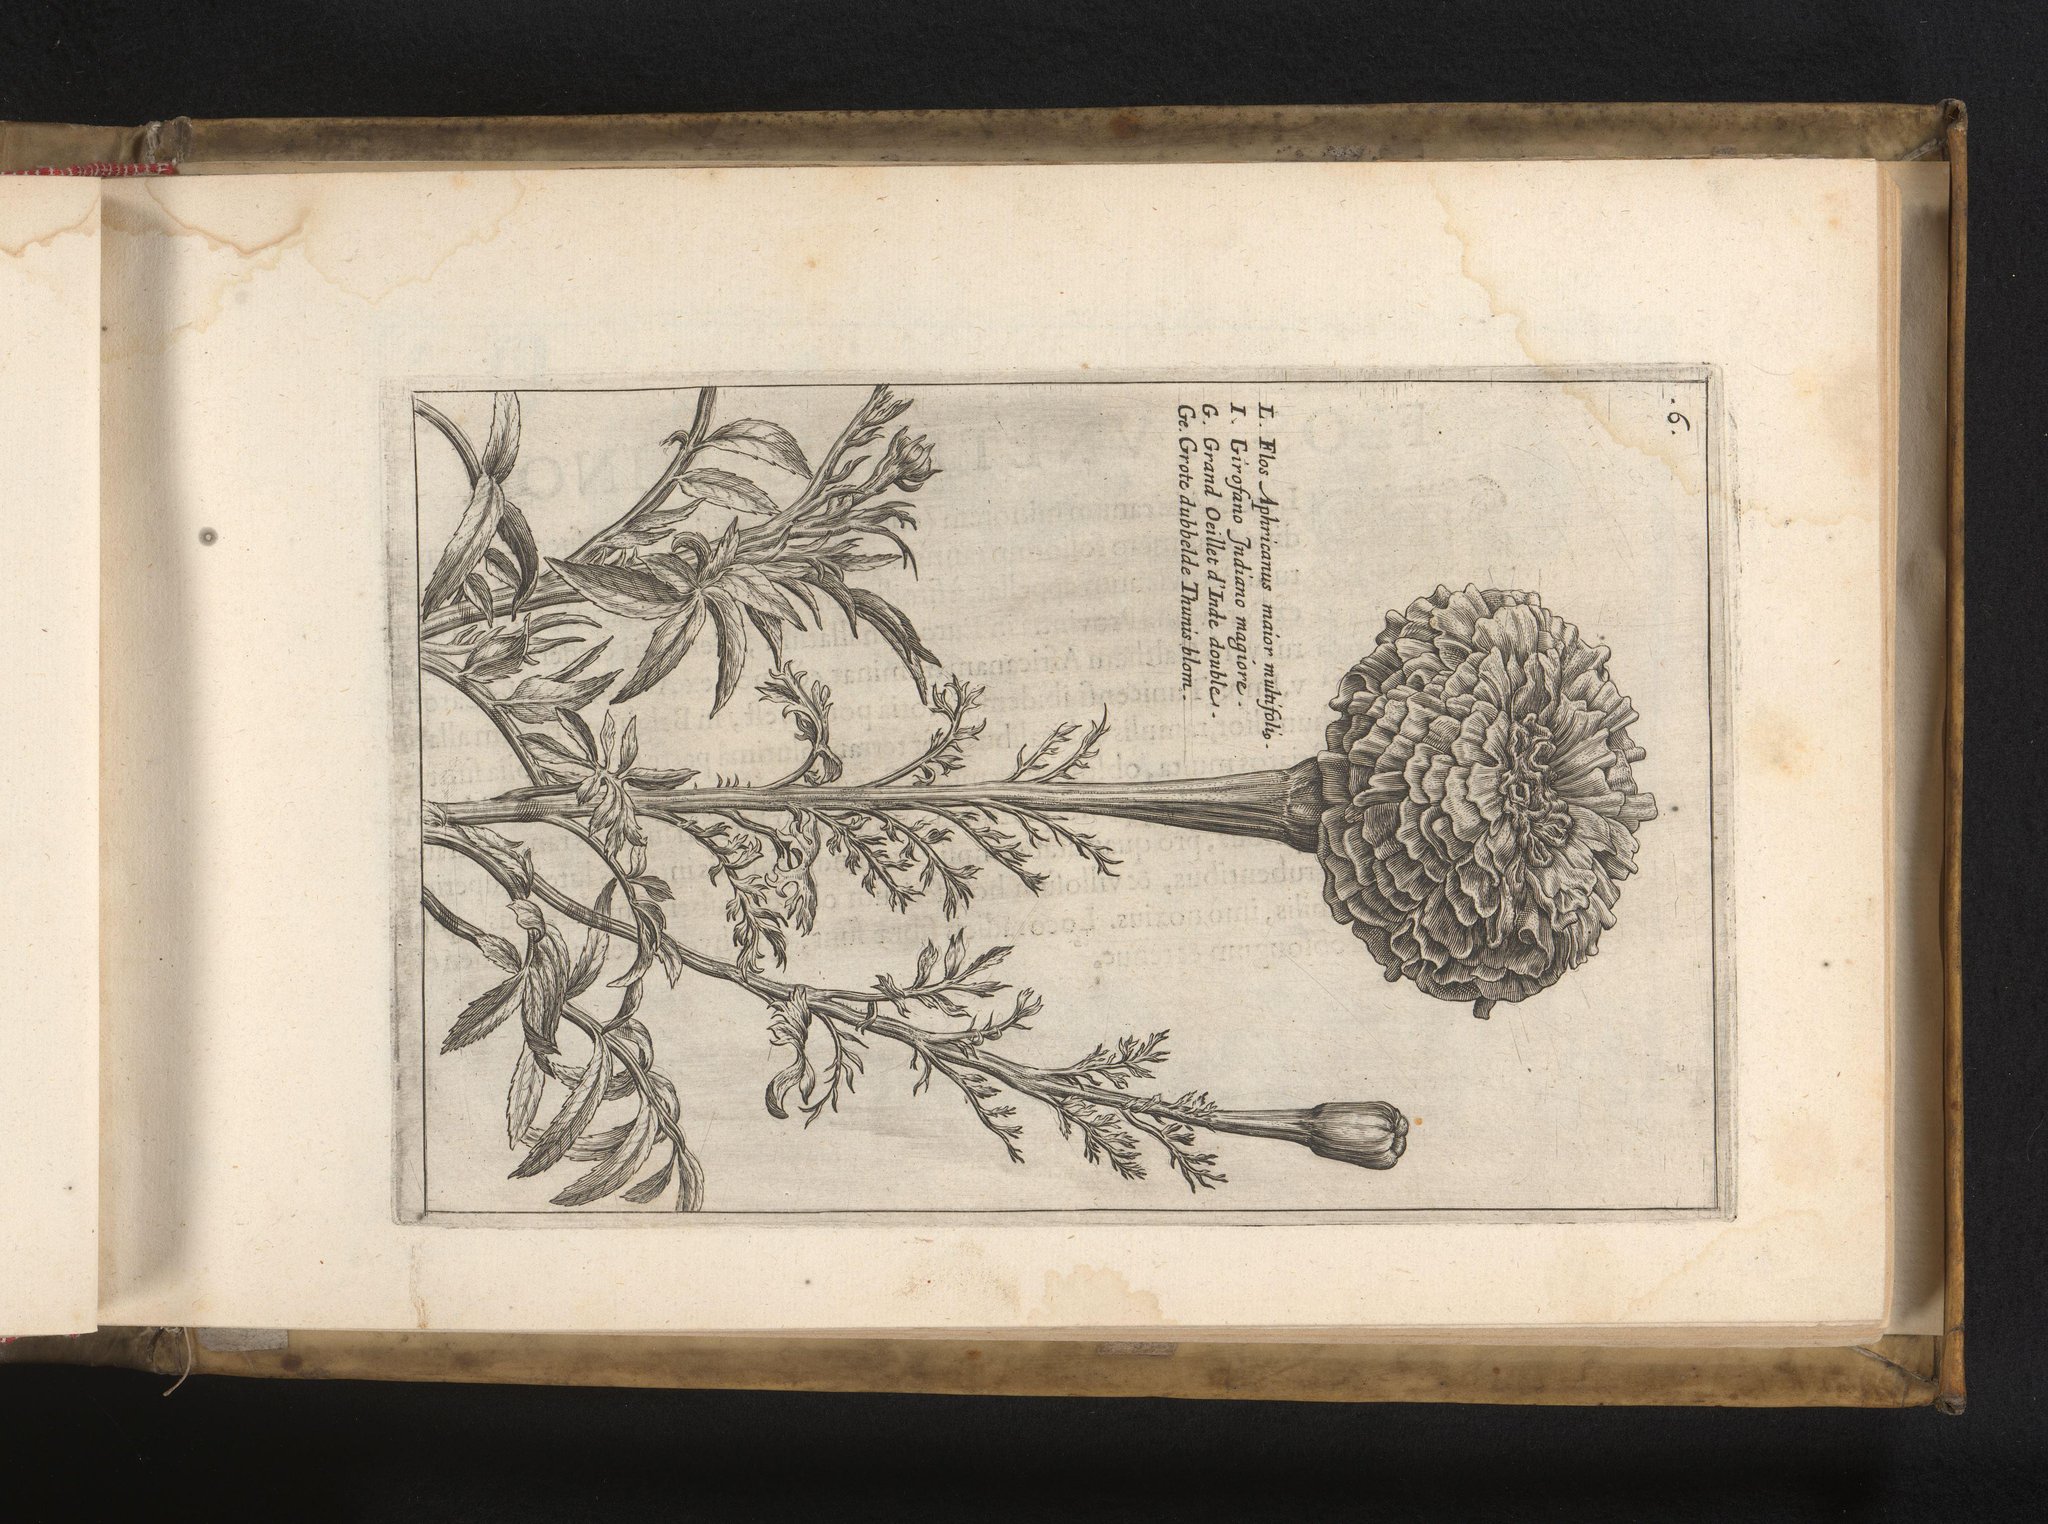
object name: page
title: Hortus floridus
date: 1617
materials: paper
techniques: engraving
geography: utrecht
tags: flowers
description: Prent uit: Passe, Crispijn van de (II). Hortus floridus in quo rariorum & minus vulgarium florum icones ad vivam veramque formam. Arnhem: Johannes Janssonius, 1617.